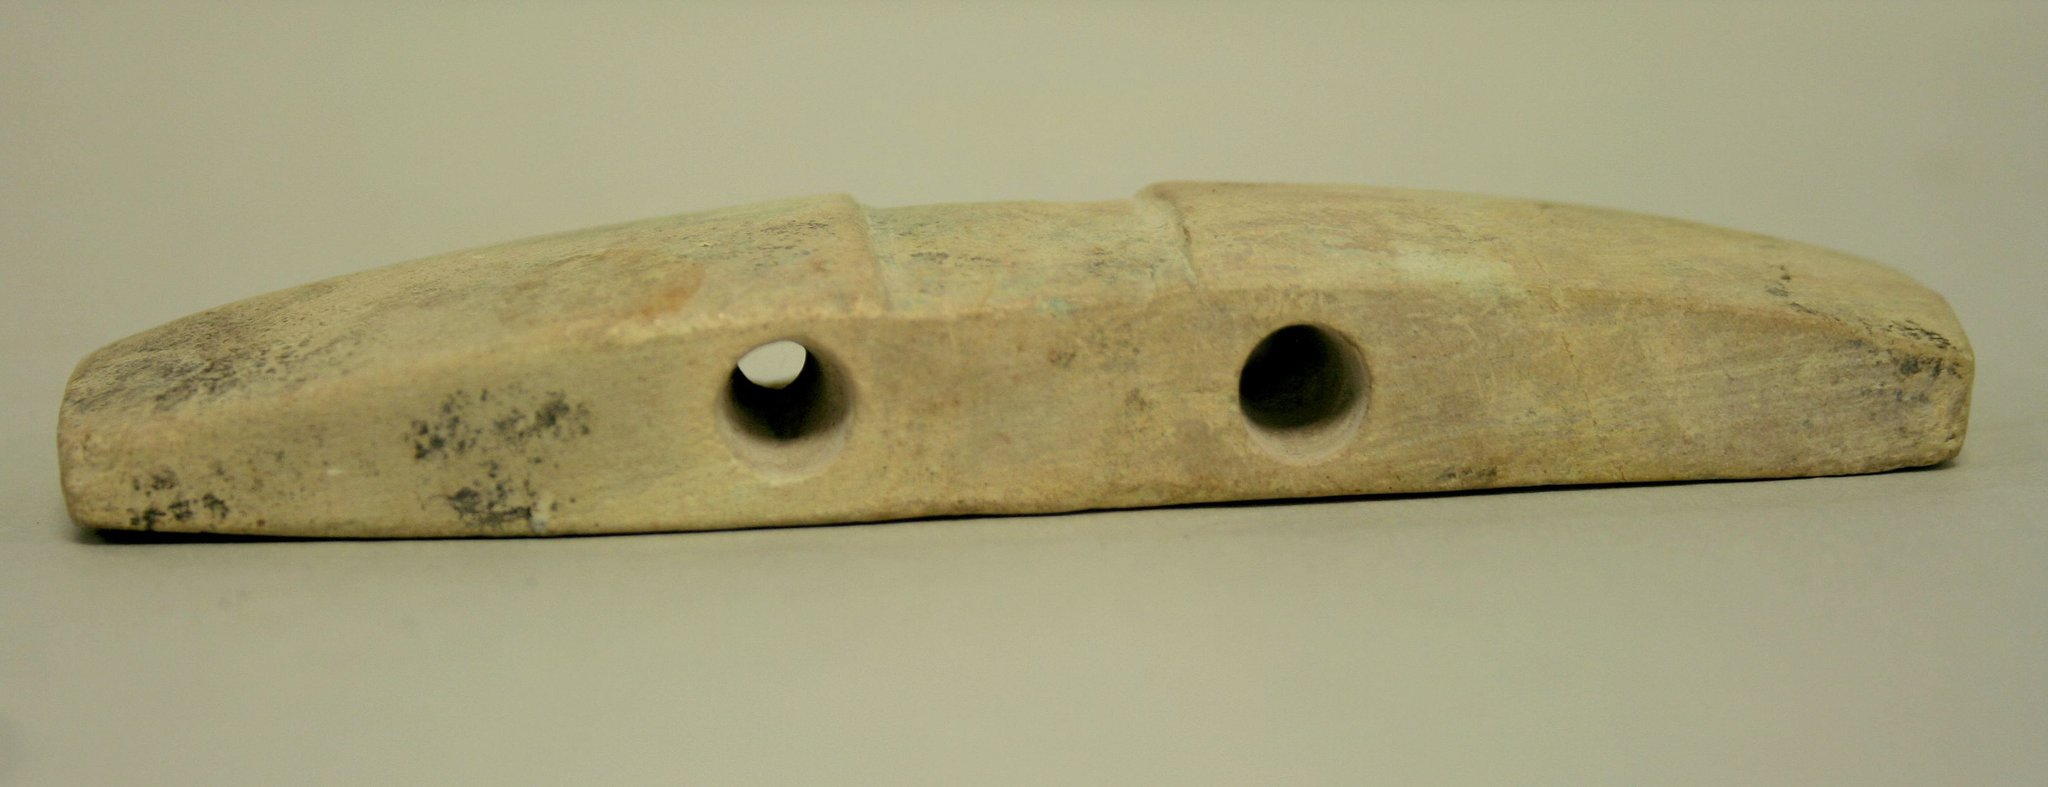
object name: pendant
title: Rectangular Stone Pendant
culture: bahian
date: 500 BCE-300 CE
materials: stone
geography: ecuador